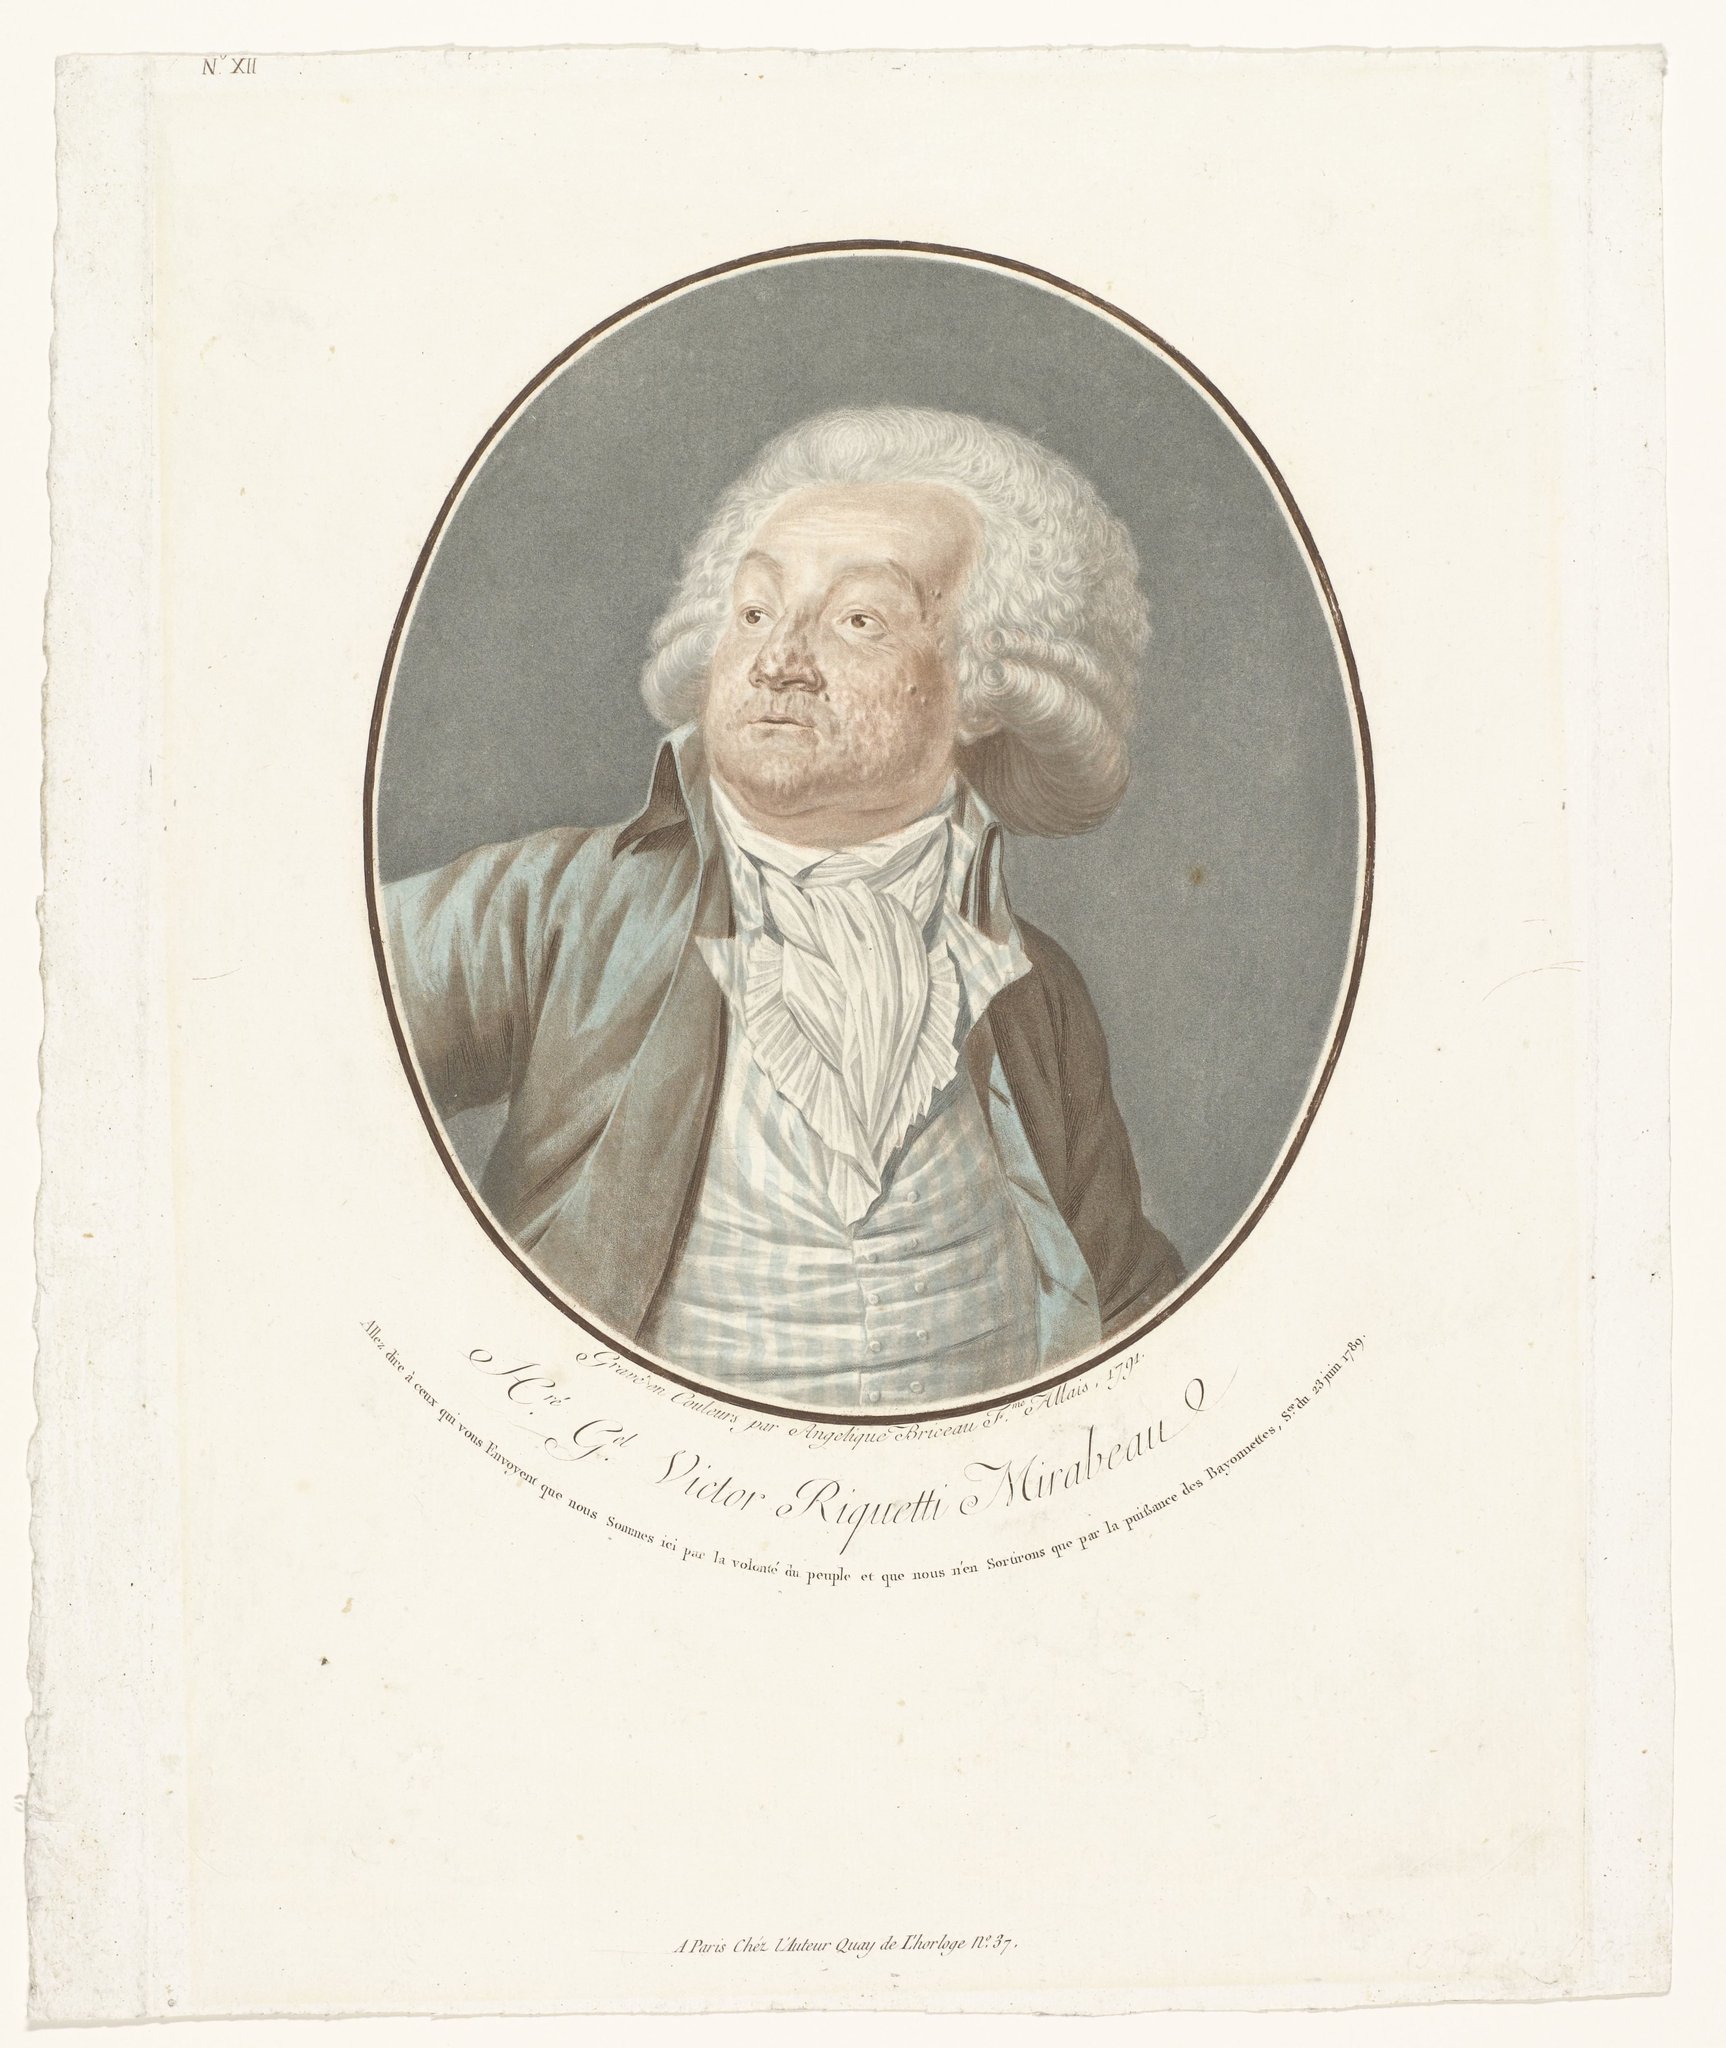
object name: print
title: Portret van Honoré Gabriël Riqueti, Graaf Mirabeau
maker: angélique briceau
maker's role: print maker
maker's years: 1767-1827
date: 1791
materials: paper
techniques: aquatint, engraving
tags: paris, politician, honoré-gabriel de riqueti (graaf van mirabeau), historical persons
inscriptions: date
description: Portretbuste van een van de kopstukken van de Franse Revolutie. Zijn gezicht is naar links gewend en toont de zware littekens als gevolg van de pokken die de geportretteerde als 3-jarig kind troffen.